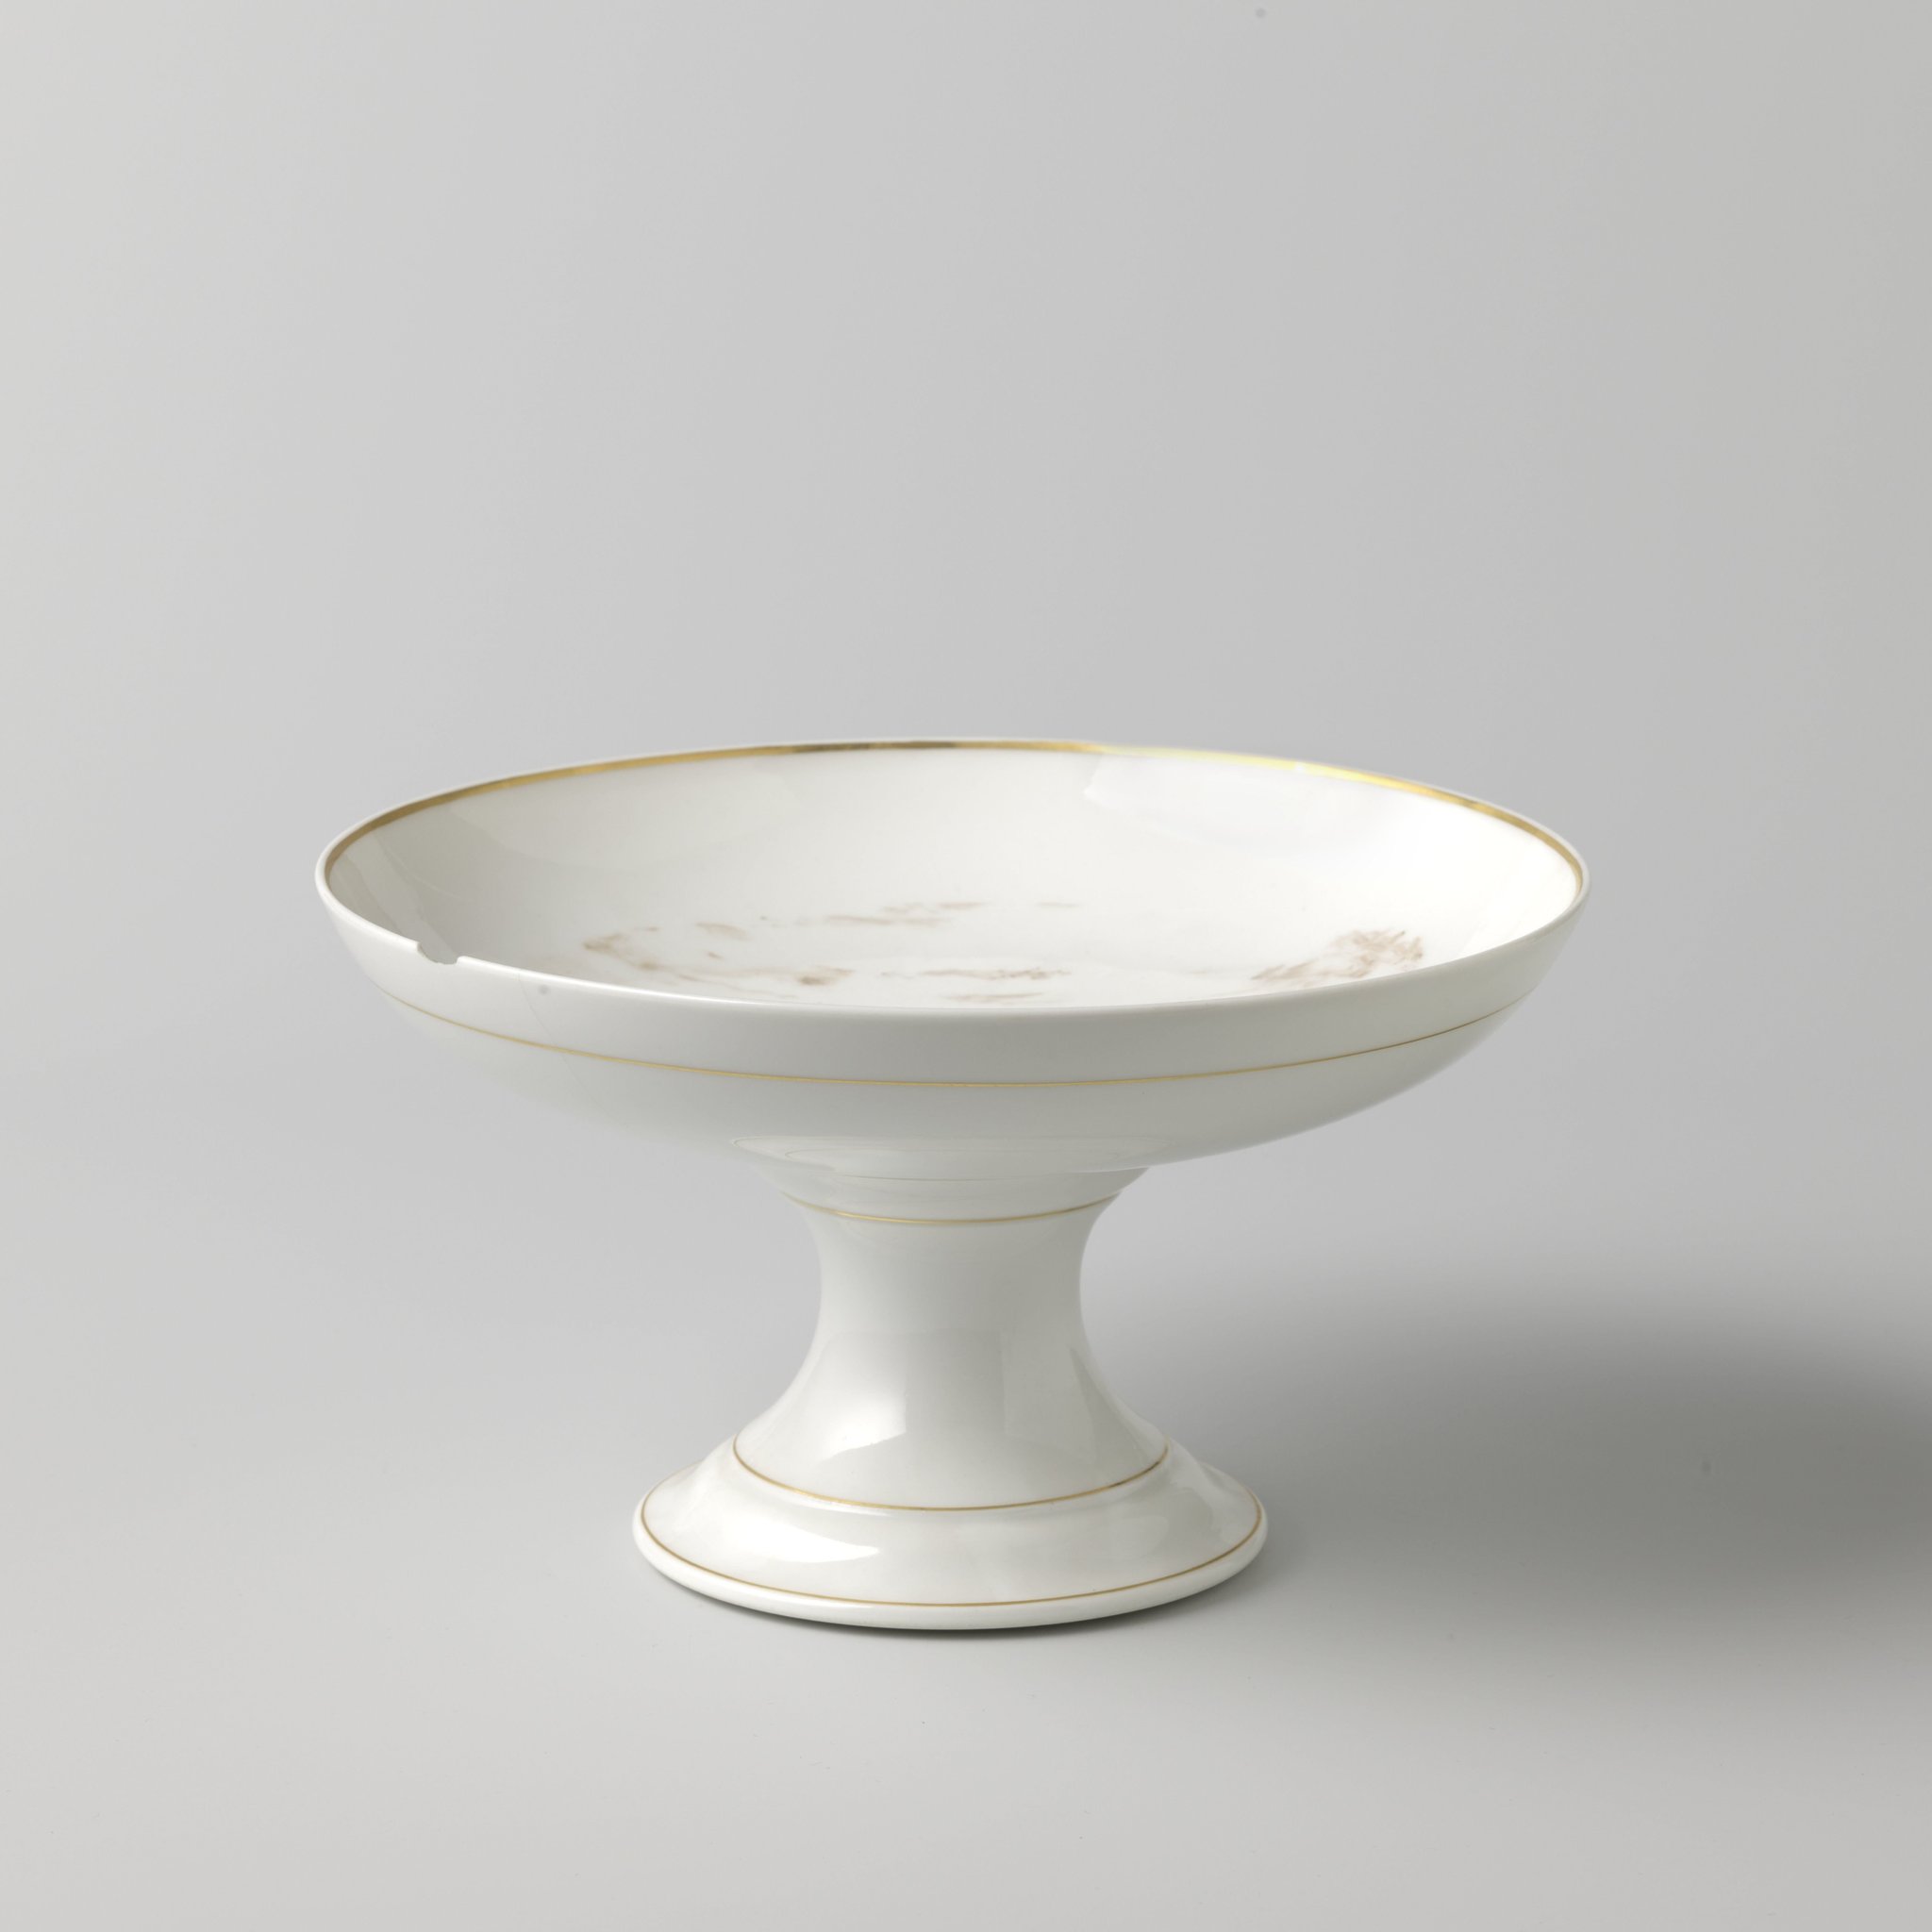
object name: service set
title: Tazza with a landscape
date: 1850-1860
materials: glaze, gold, paint, porcelain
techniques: firing, forming, gilding, turning, vitrification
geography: europe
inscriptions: mark: ‘A.V./ M’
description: Tazza van porselein op een hoge, spreidende voet, beschilderd op het glazuur in sepia en goud. Op het plat een persoon in een waterlandschap met twee aangemeerde boten, een huis, bergen en bomen. Gouden rand en gouden lijnen op de buitenwand en de voet. Gemerkt op de onderzijde met A.V. en M.